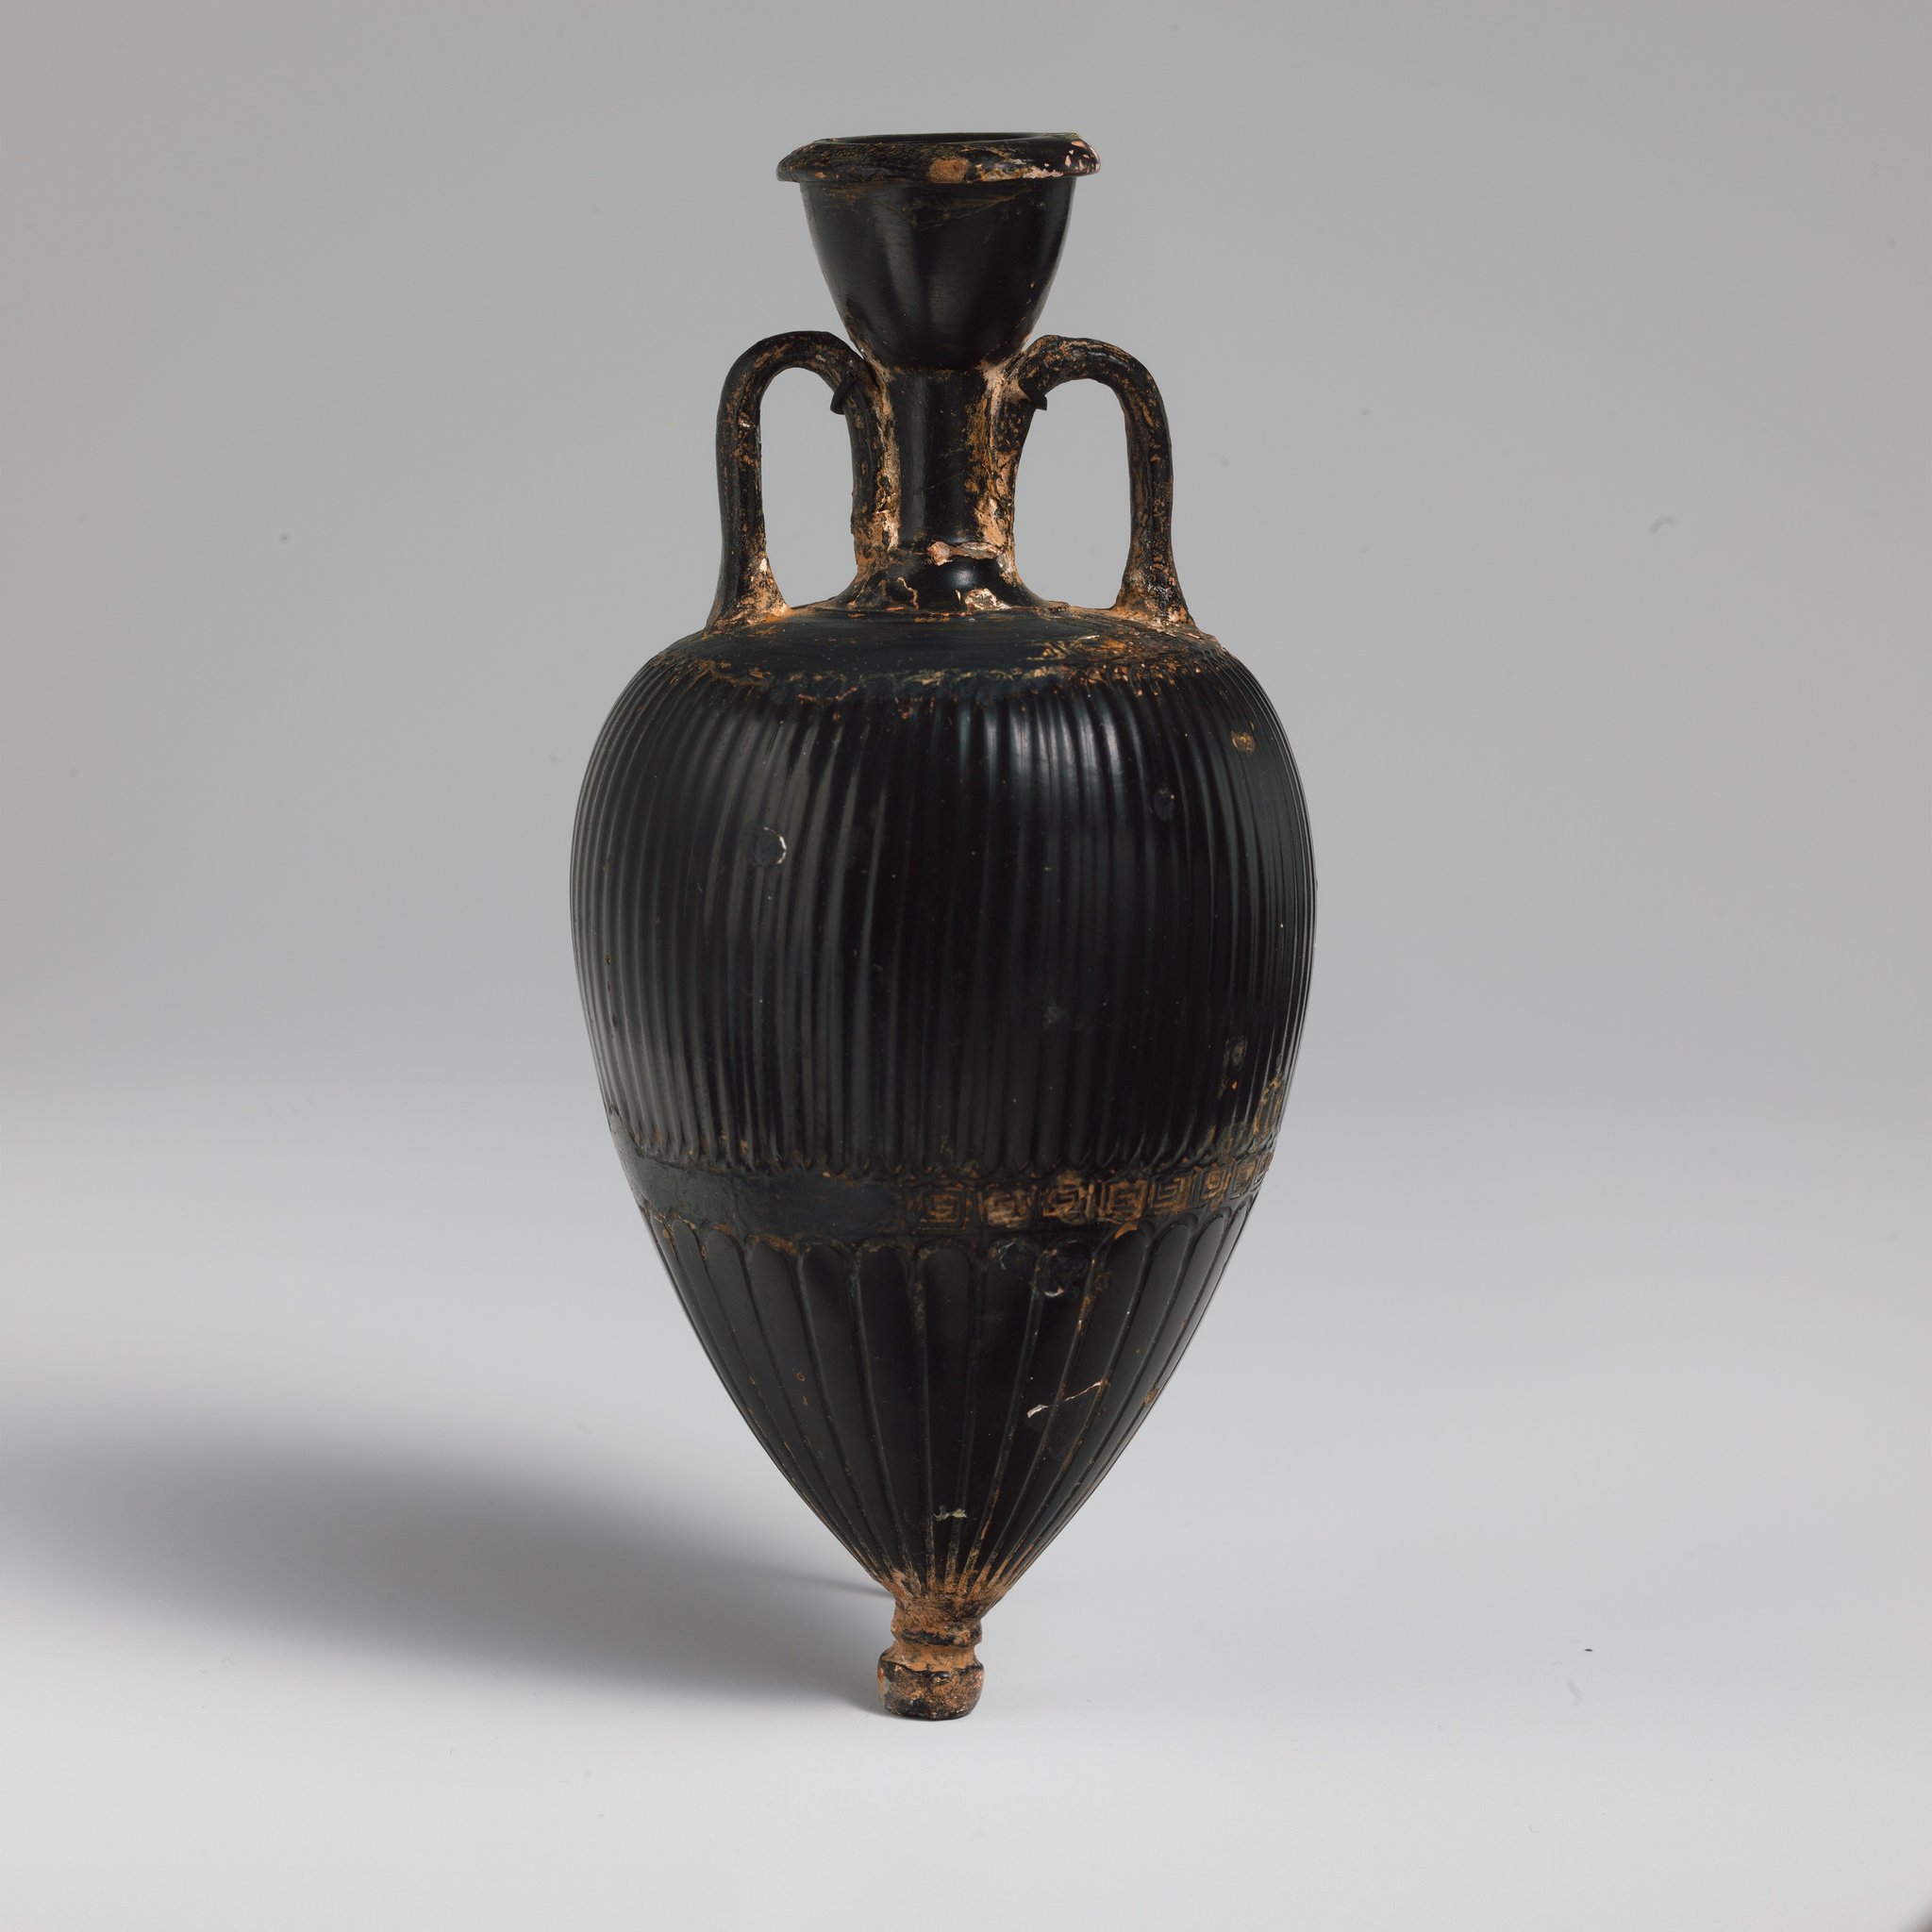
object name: amphoriskos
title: Terracotta amphoriskos (oil flask)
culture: greek, attic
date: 400-301 BCE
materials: terracotta